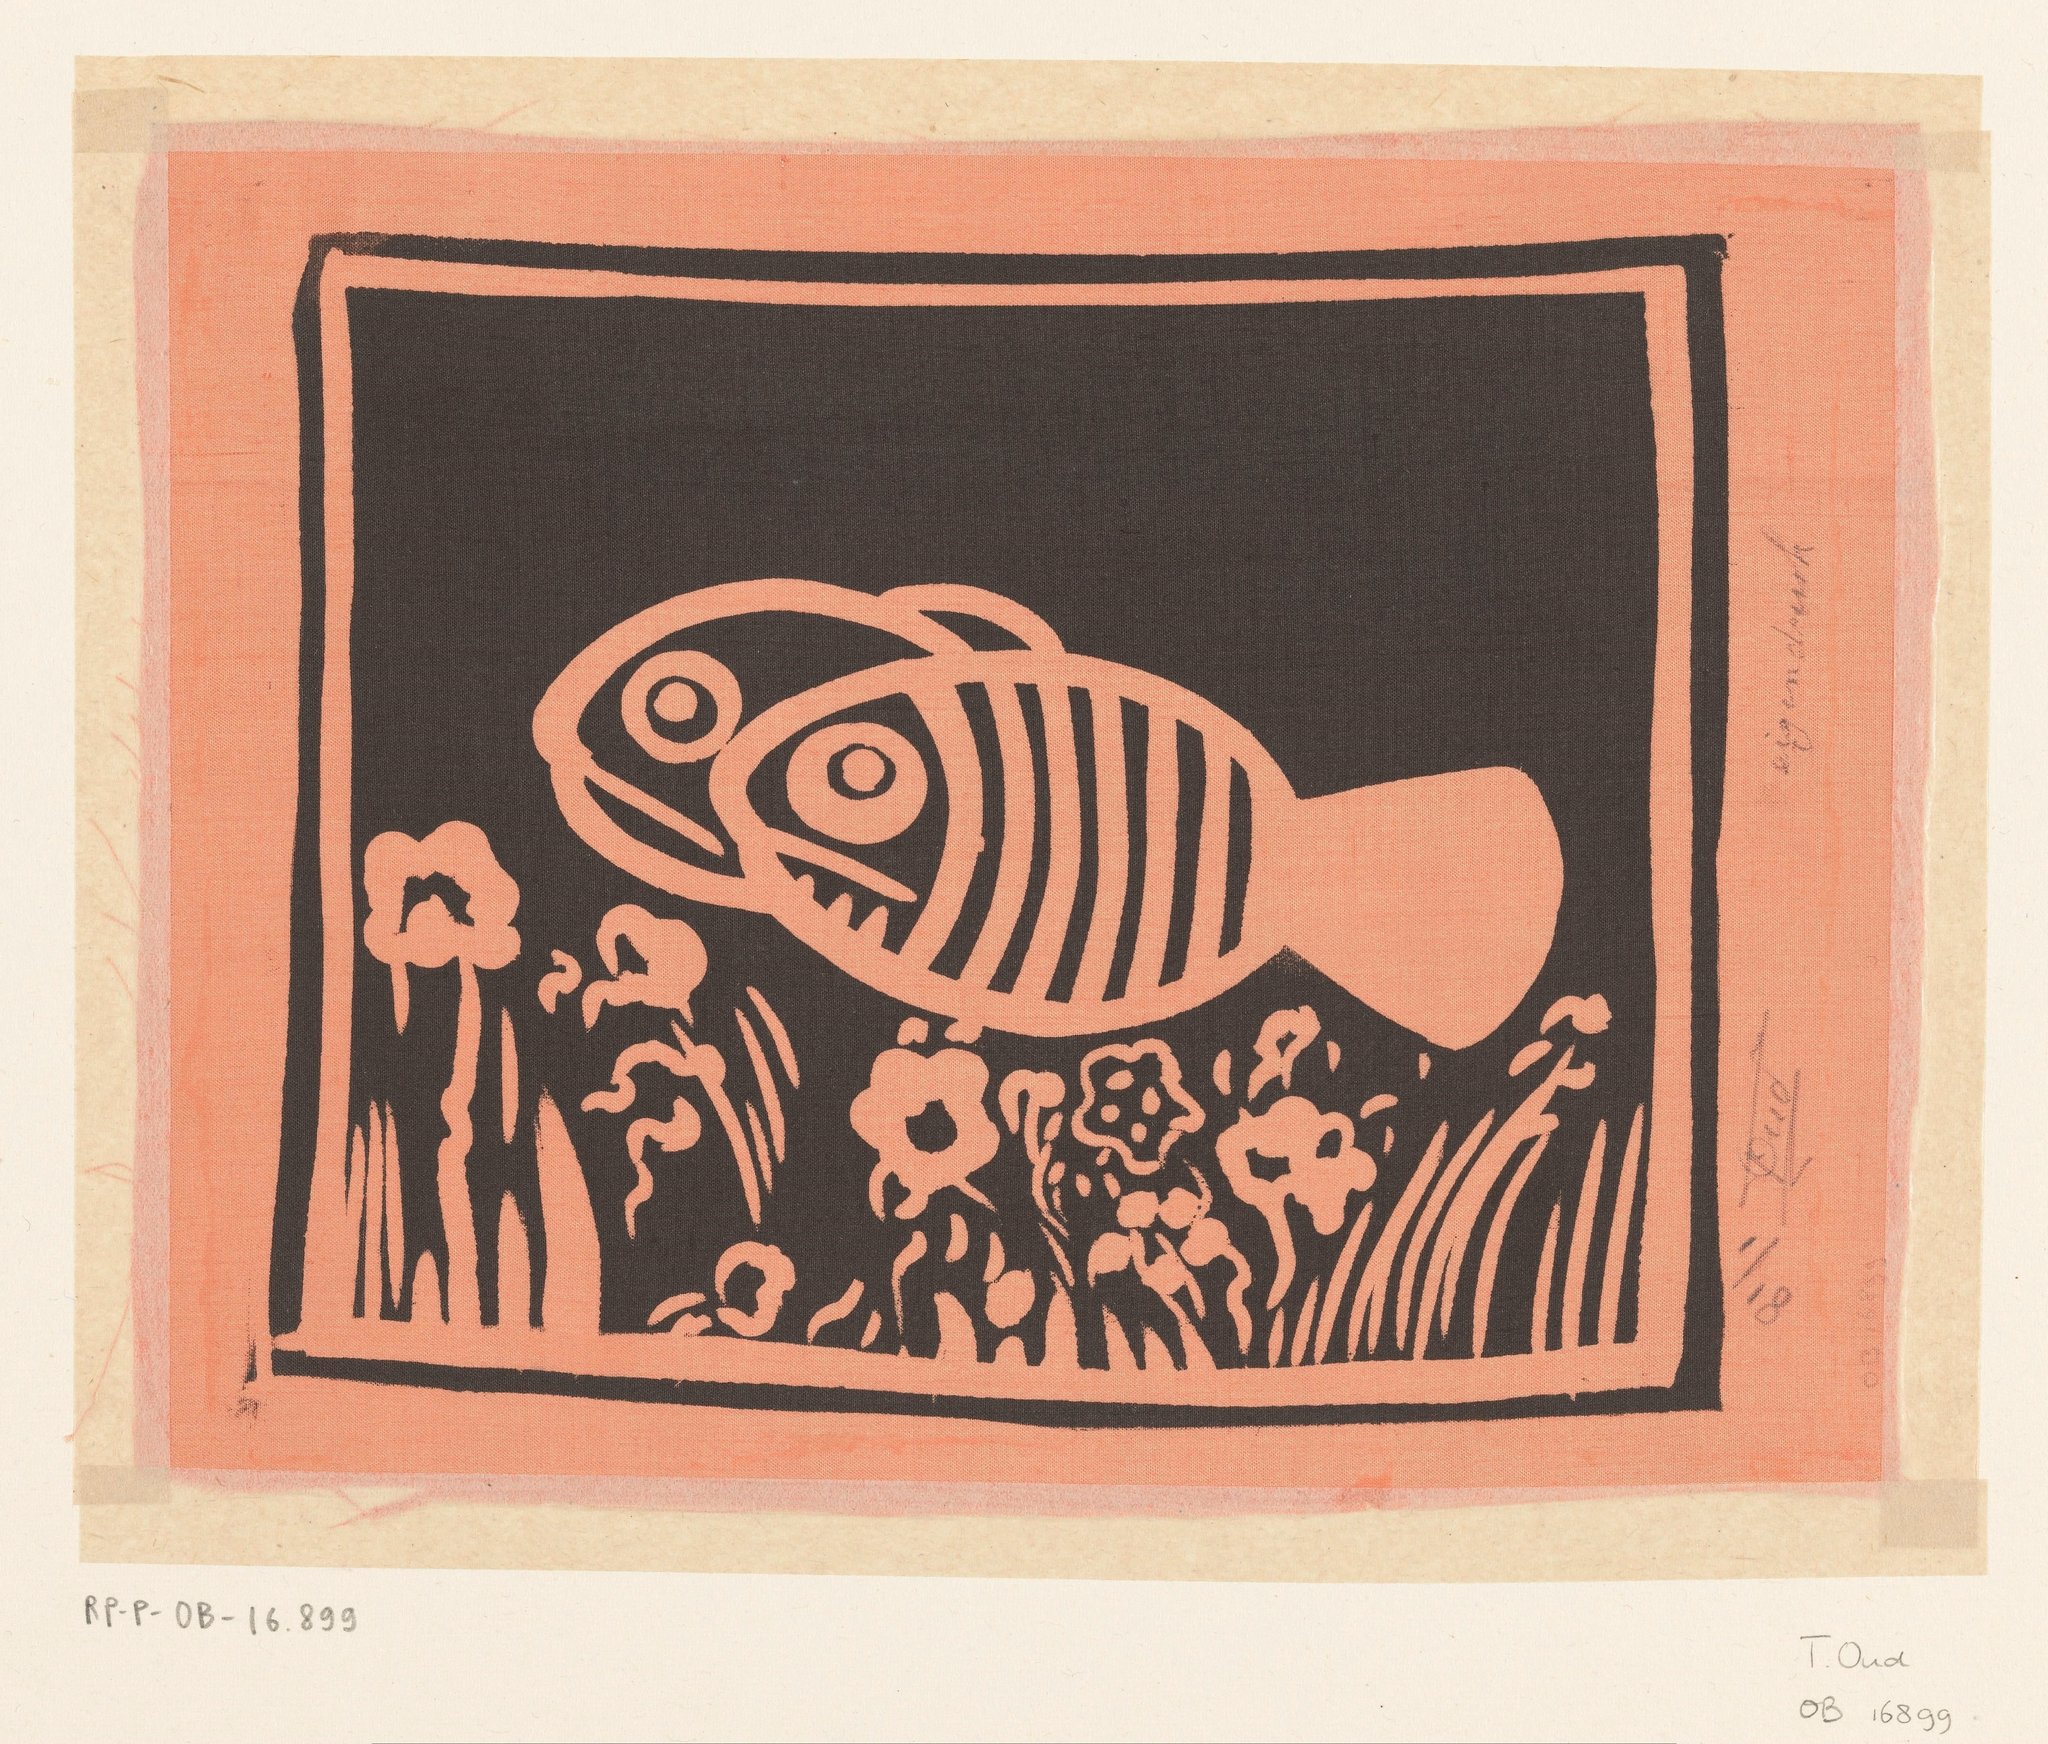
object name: print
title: Twee vissen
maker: tames oud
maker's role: print maker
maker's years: 1895-1953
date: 1905-1953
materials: silk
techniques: woodcut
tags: flowers, fishes